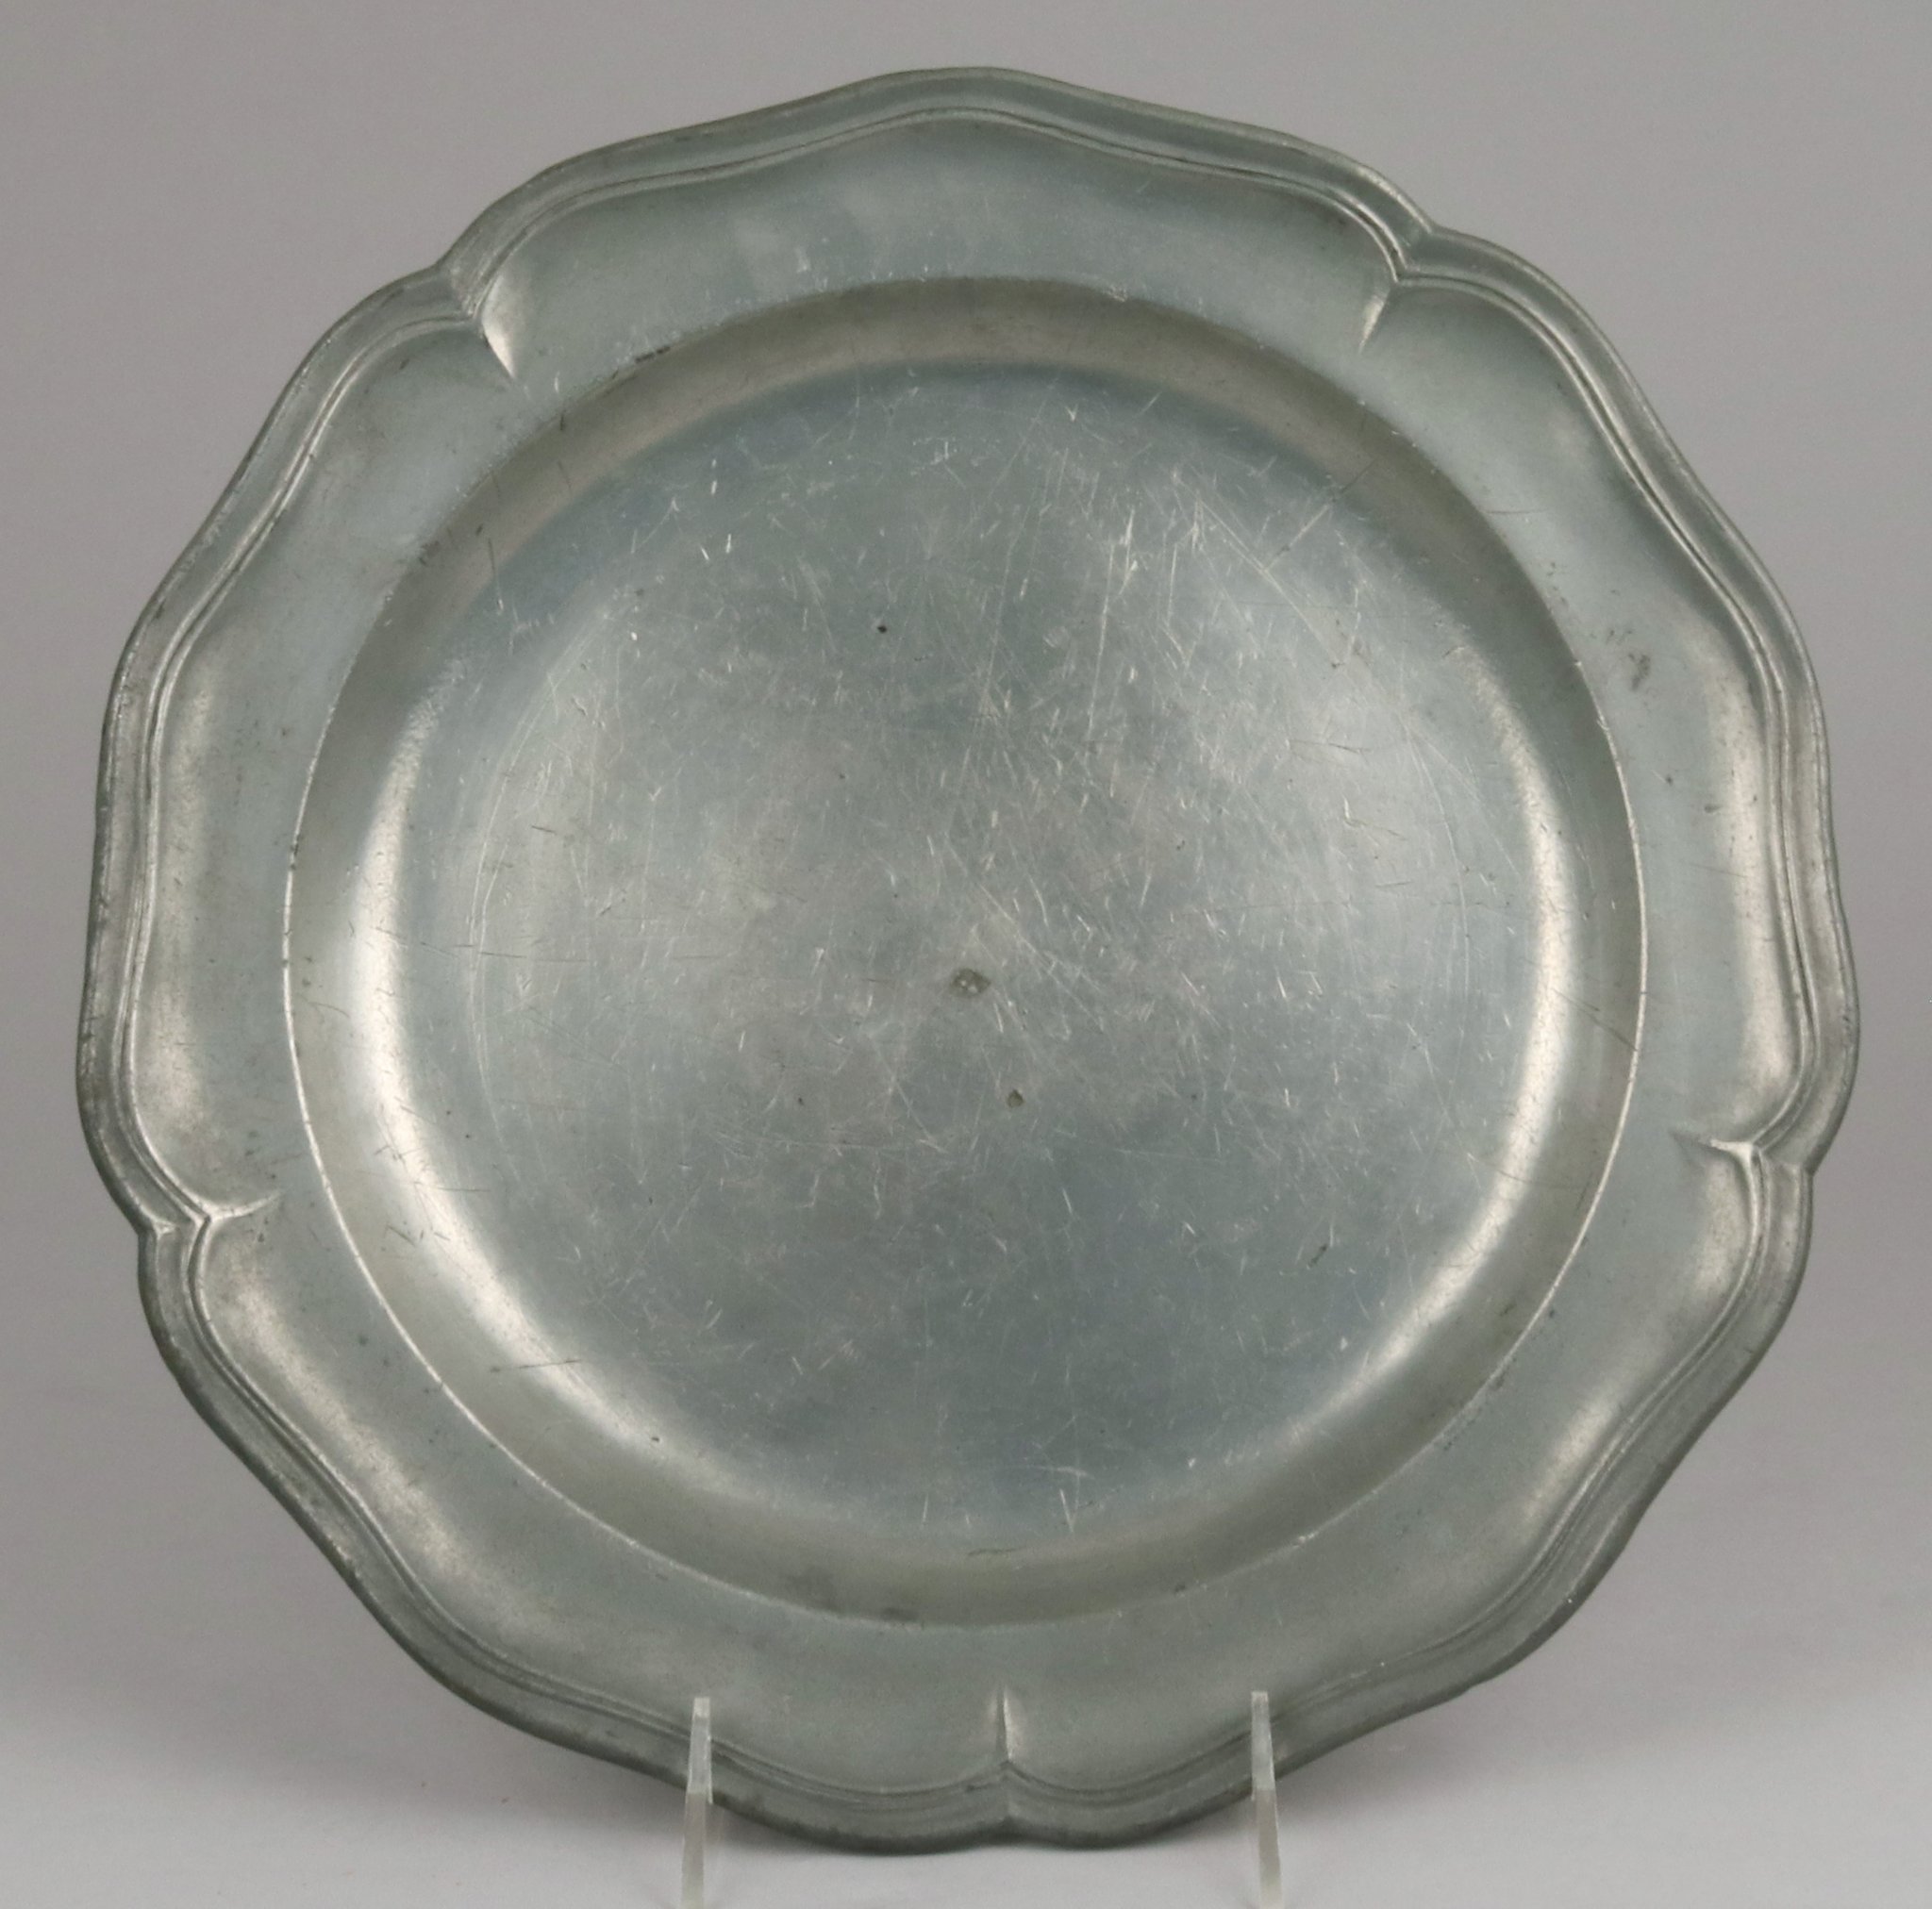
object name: plate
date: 1801-1900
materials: pewter